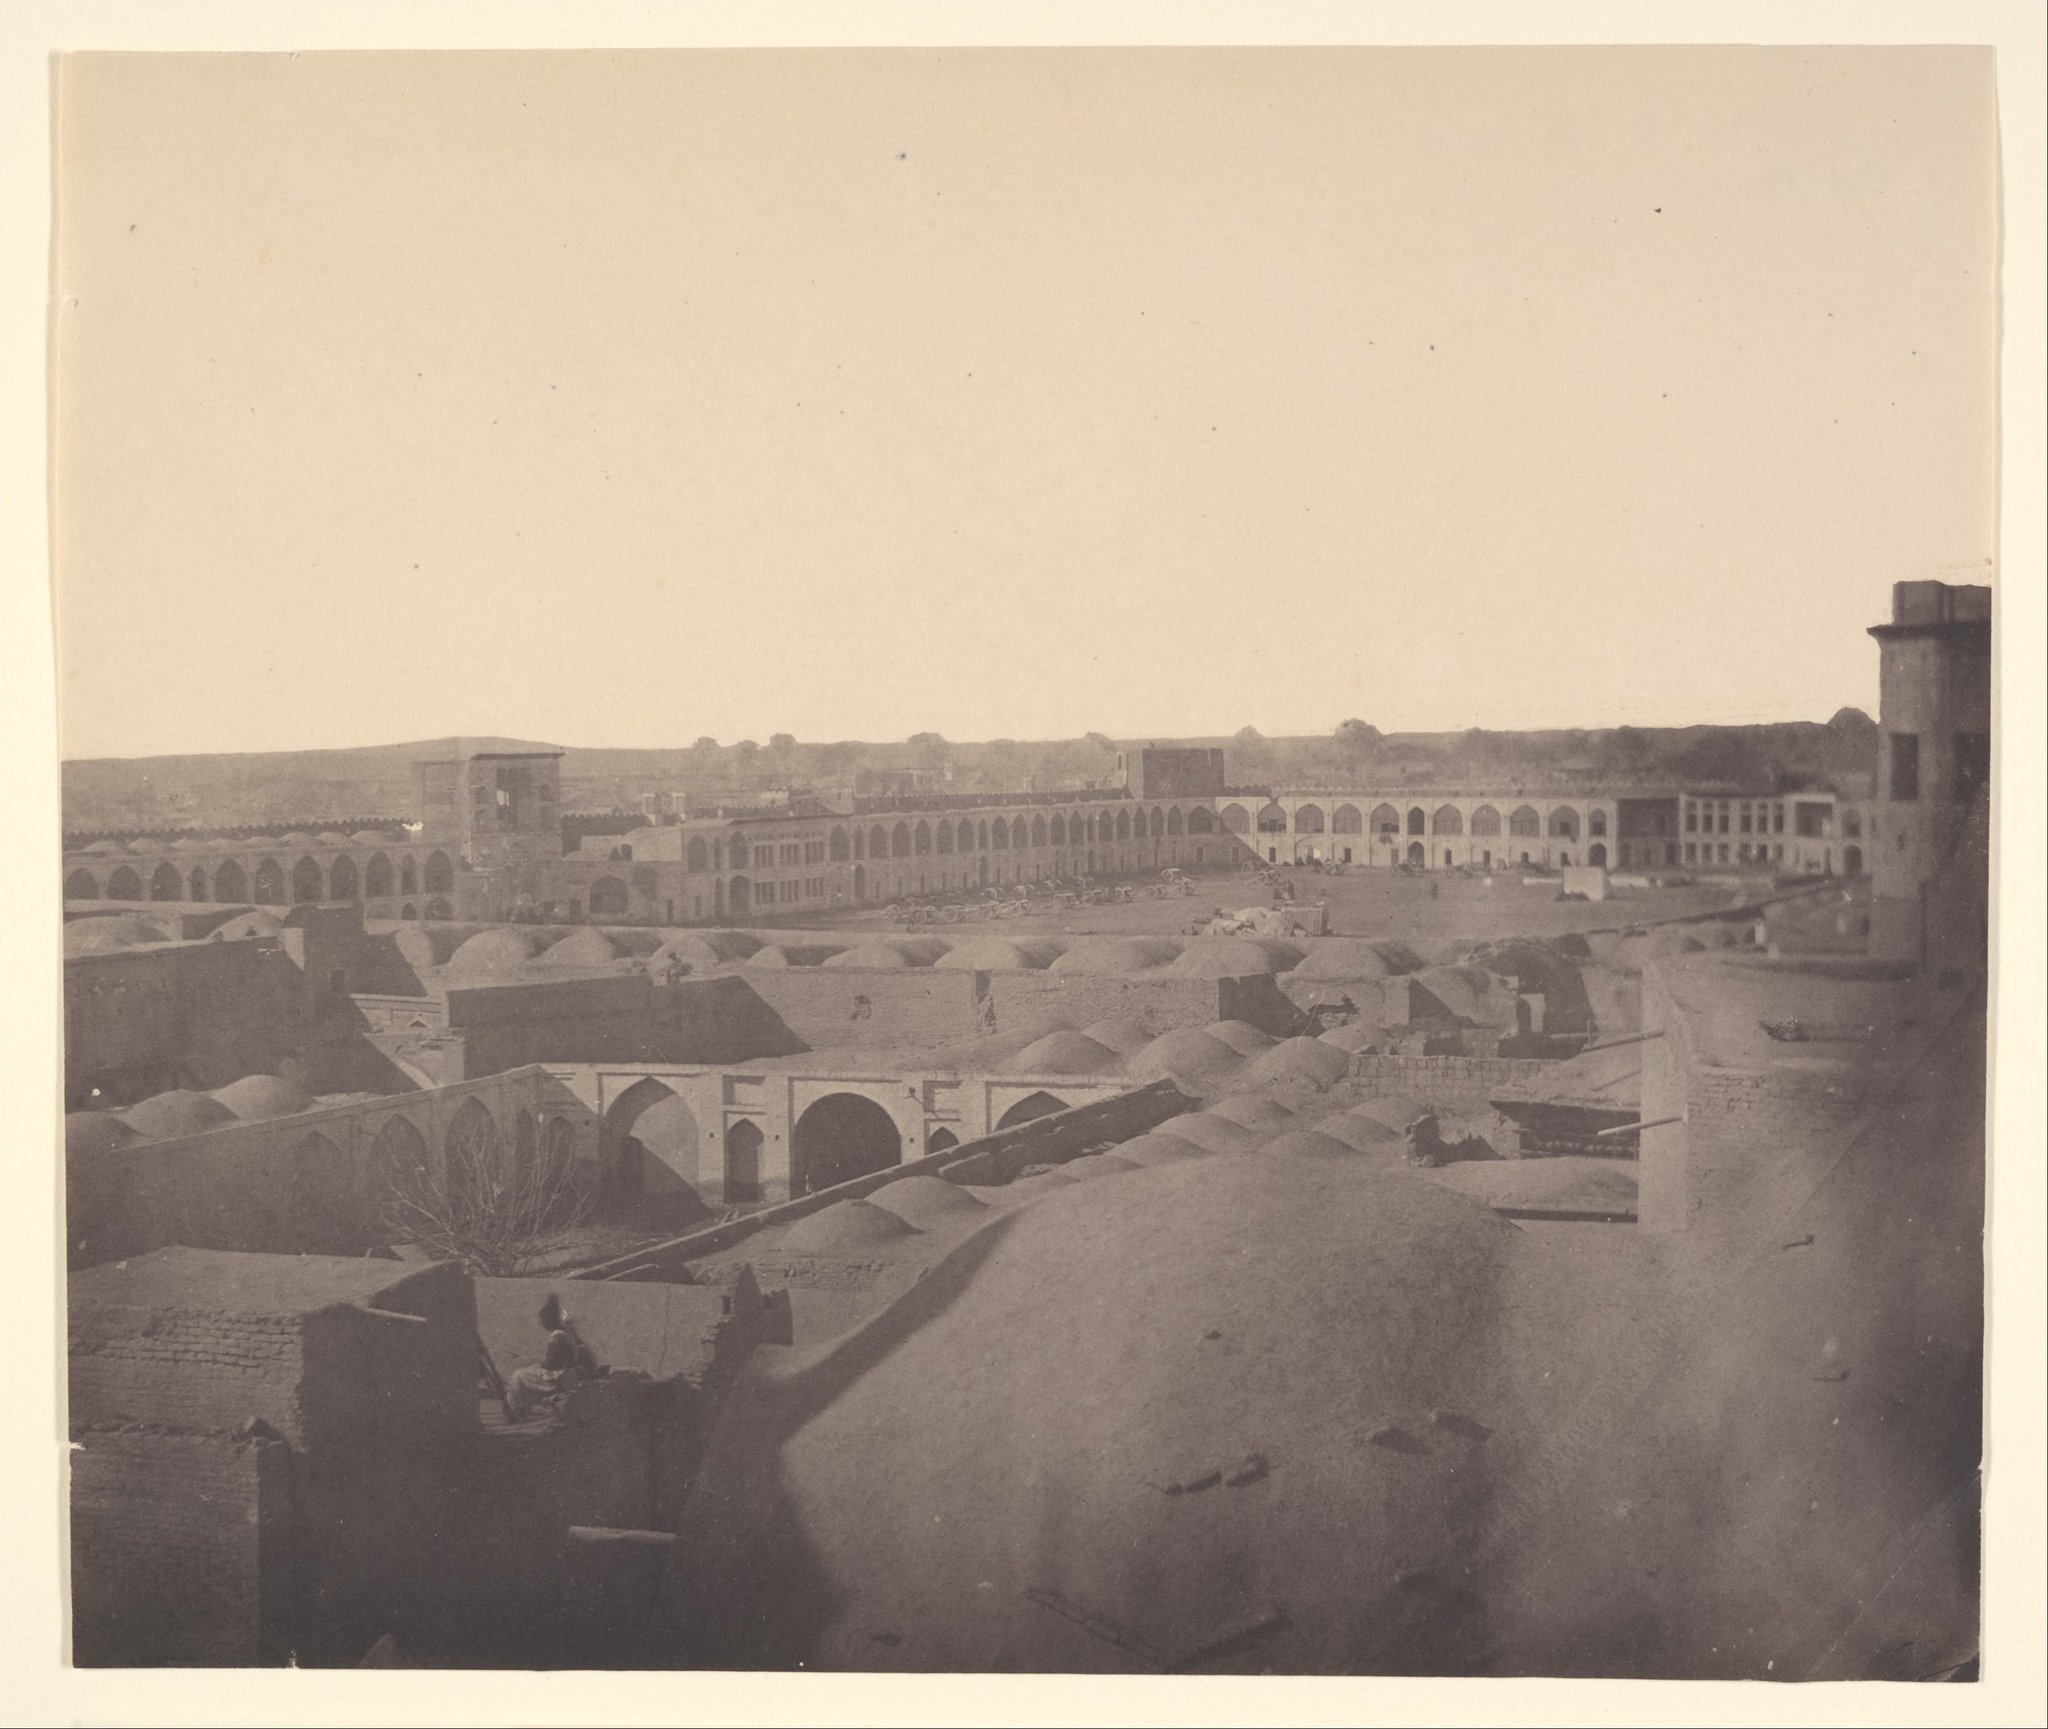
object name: photograph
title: [Plaza of Canons, Teheran, Iran] (Maydan-i Top-khaneh)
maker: luigi pesce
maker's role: artist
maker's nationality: italian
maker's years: 1818-1891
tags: architecture,buildings